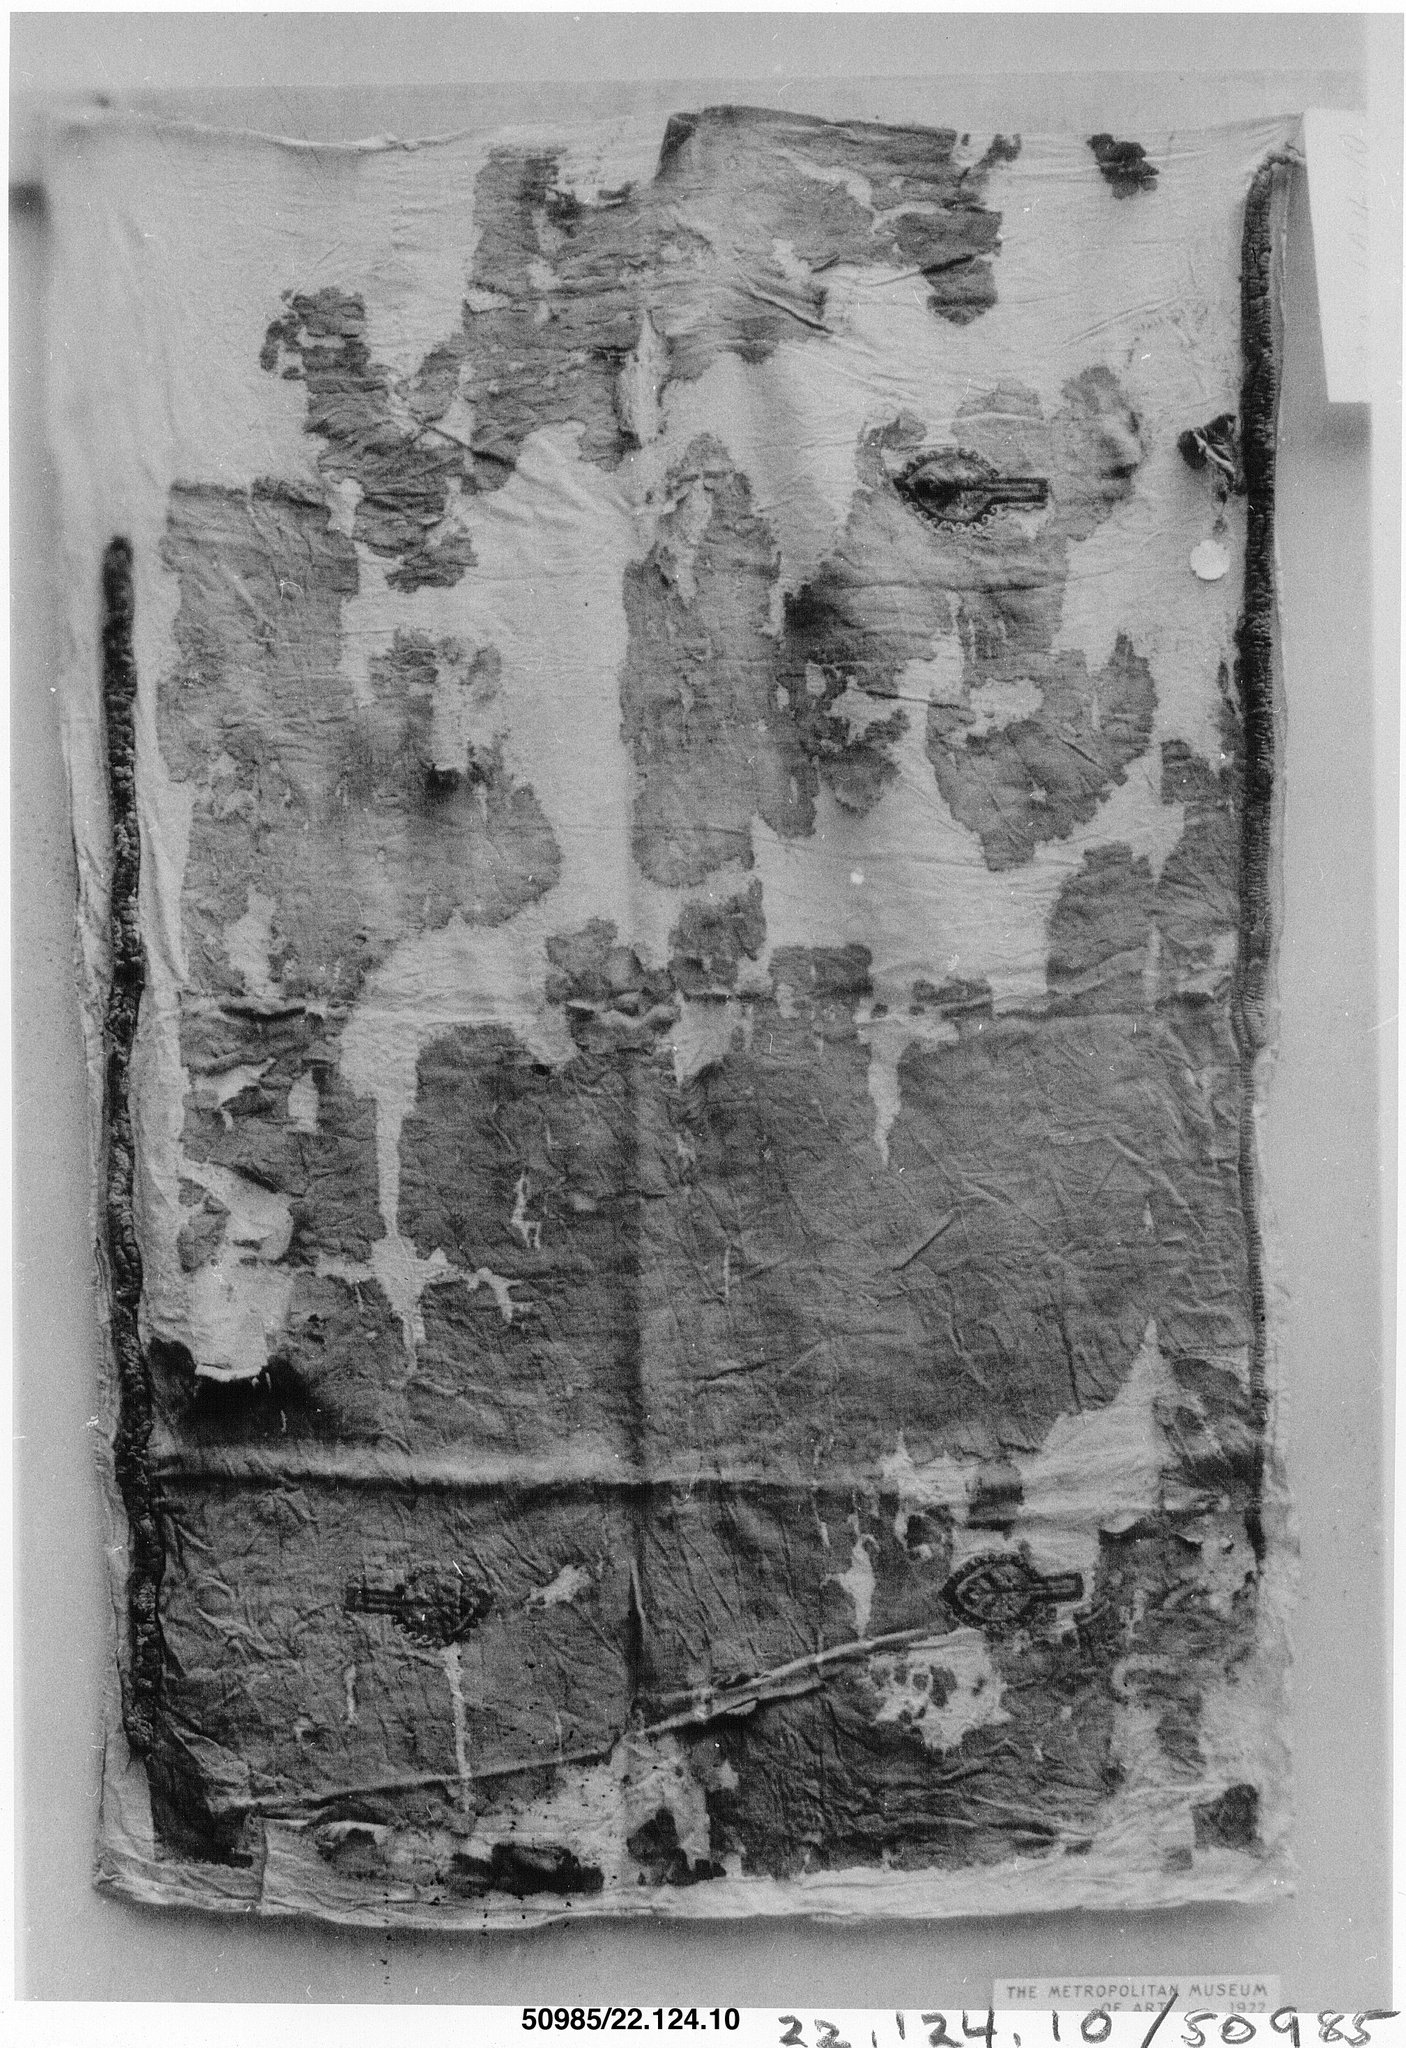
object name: fragment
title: Textile Fragment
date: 301-600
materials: linen, wool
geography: egypt